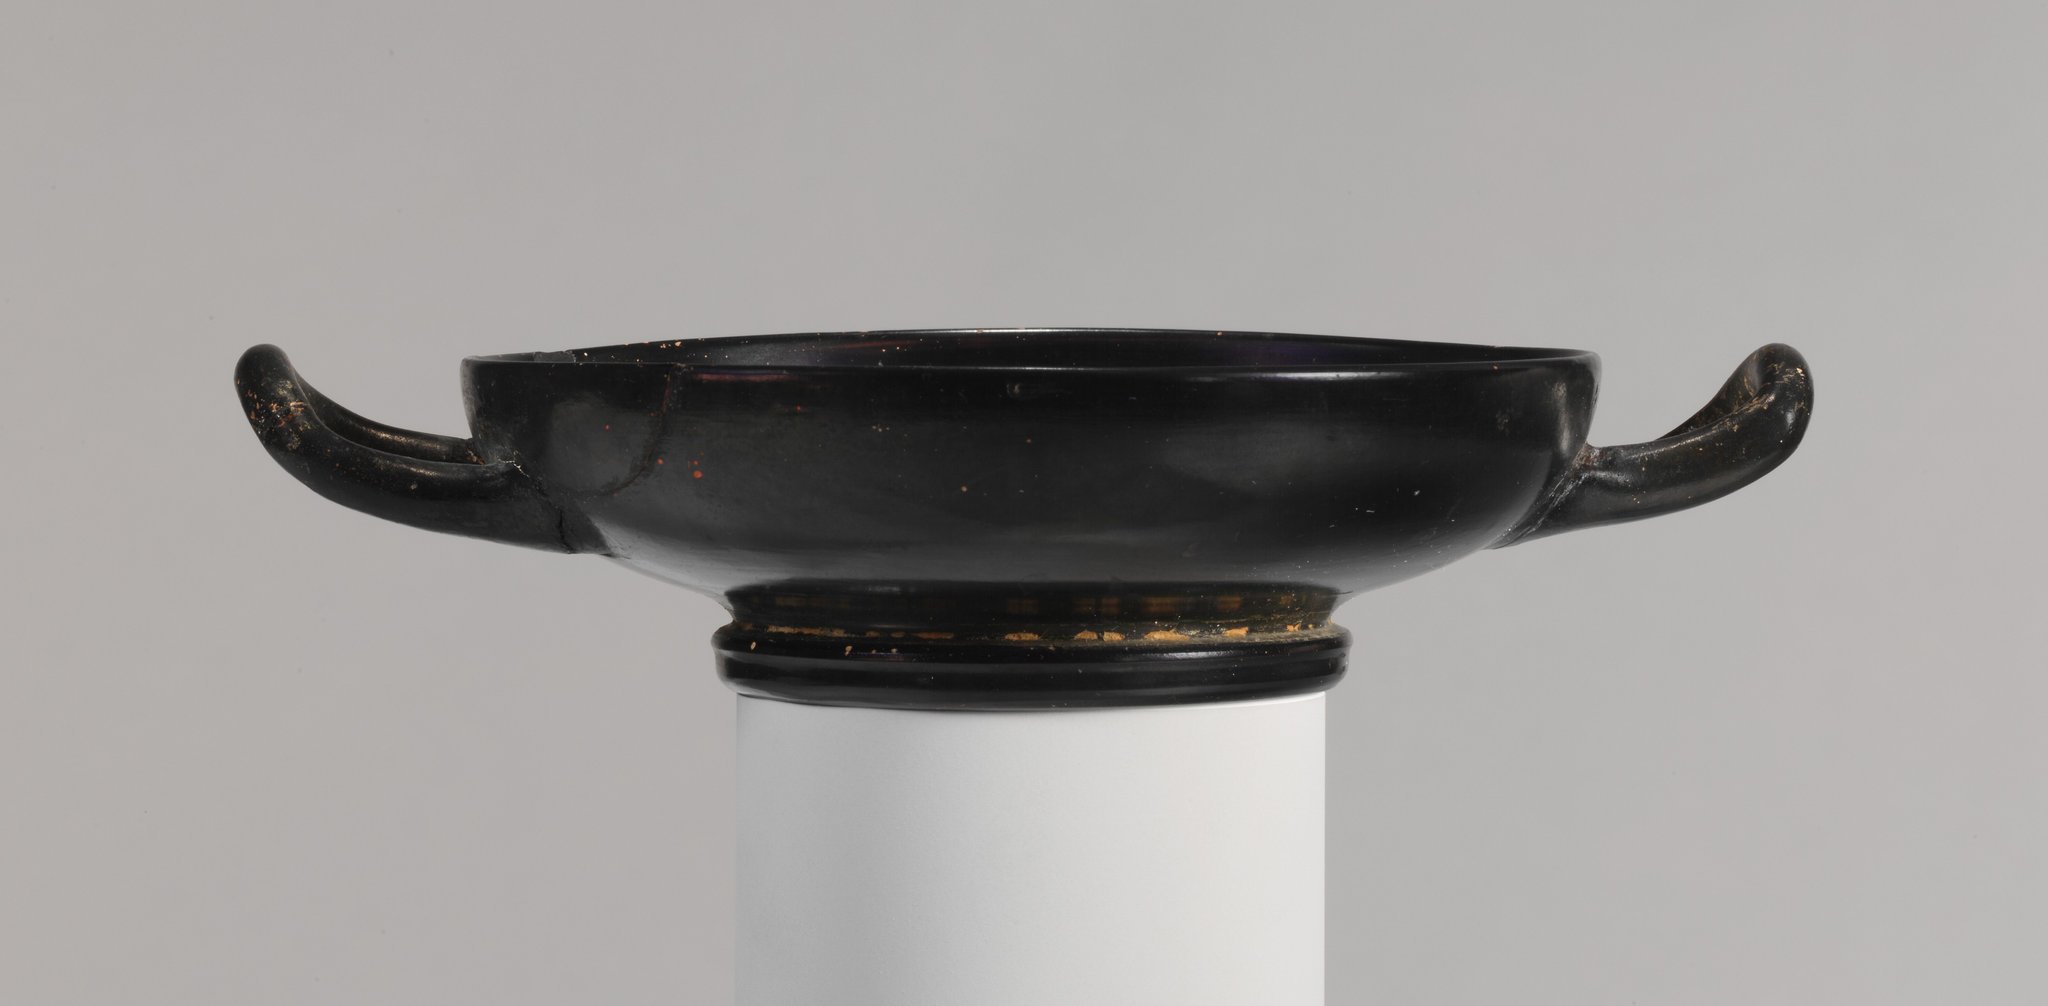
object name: kylix, stemless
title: Terracotta stemless kylix (drinking cup)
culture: greek, attic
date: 500-401 BCE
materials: terracotta